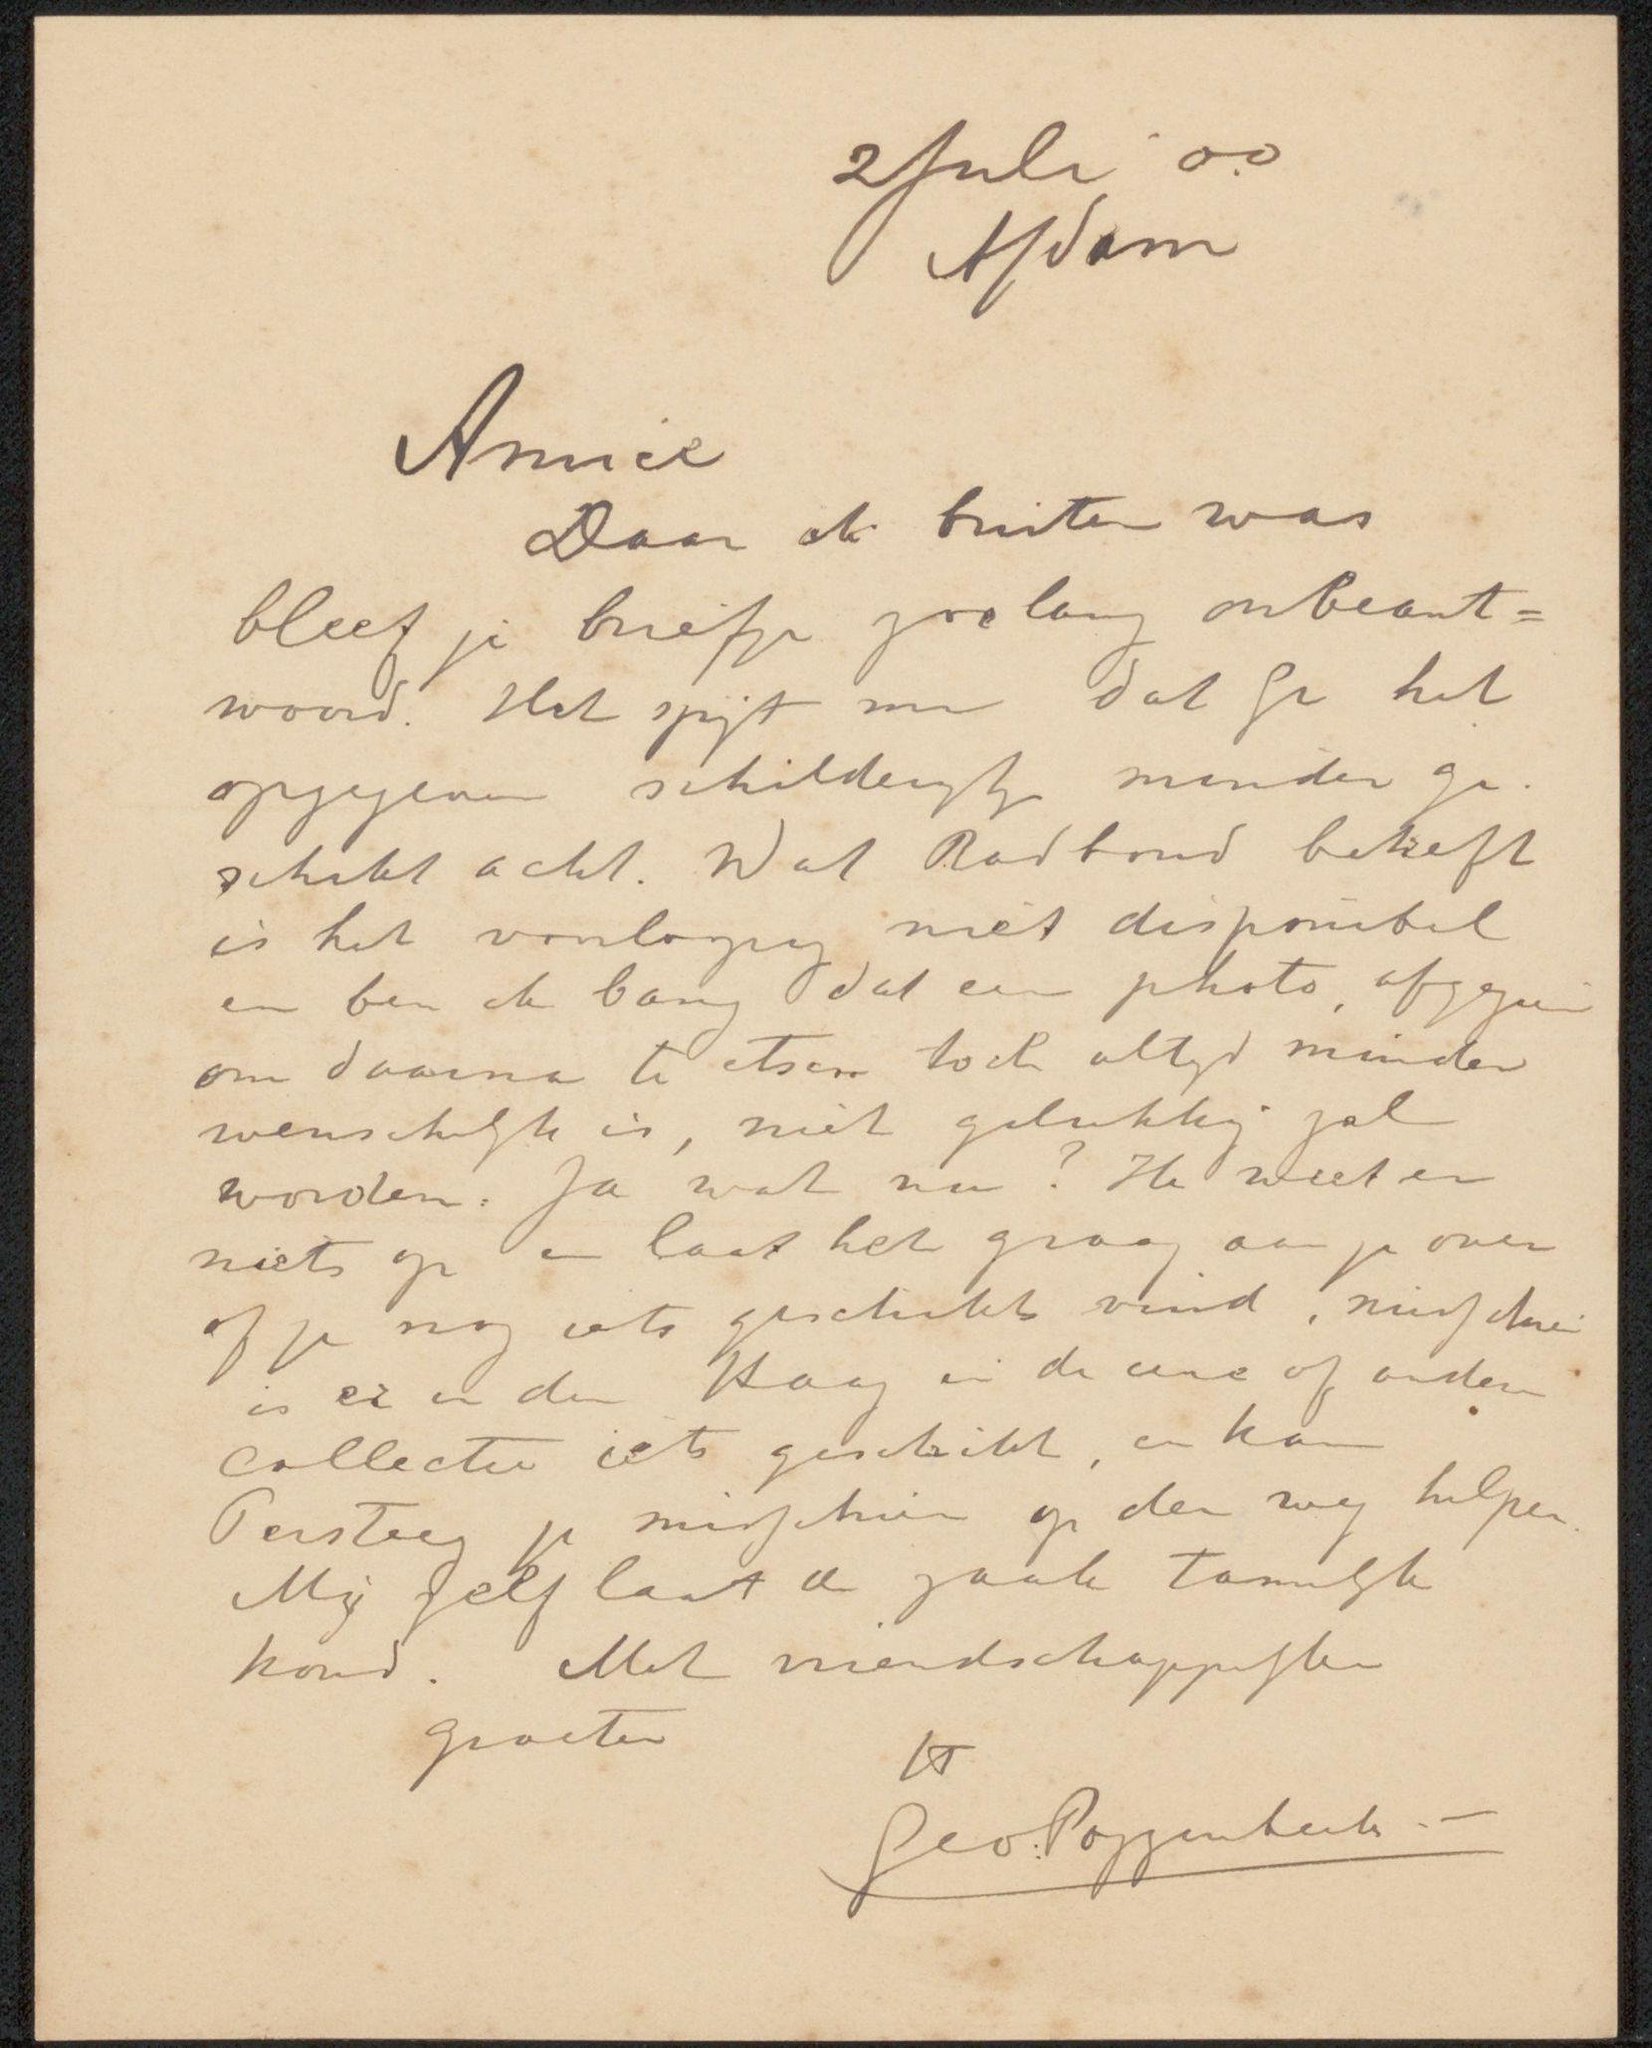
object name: letter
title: Brief aan Philip Zilcken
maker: geo poggenbeek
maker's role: draughtsman, painter, print maker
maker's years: 1853-1903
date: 1900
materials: ink, paper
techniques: pen, writing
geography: amsterdam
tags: hermanus gijsbertus tersteeg, the hague, painter, draughtsman, philip zilcken, photography, cinematography, the graphic arts, painting (including book-illumination, miniature-painting)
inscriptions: collector's mark: ‘RPK’